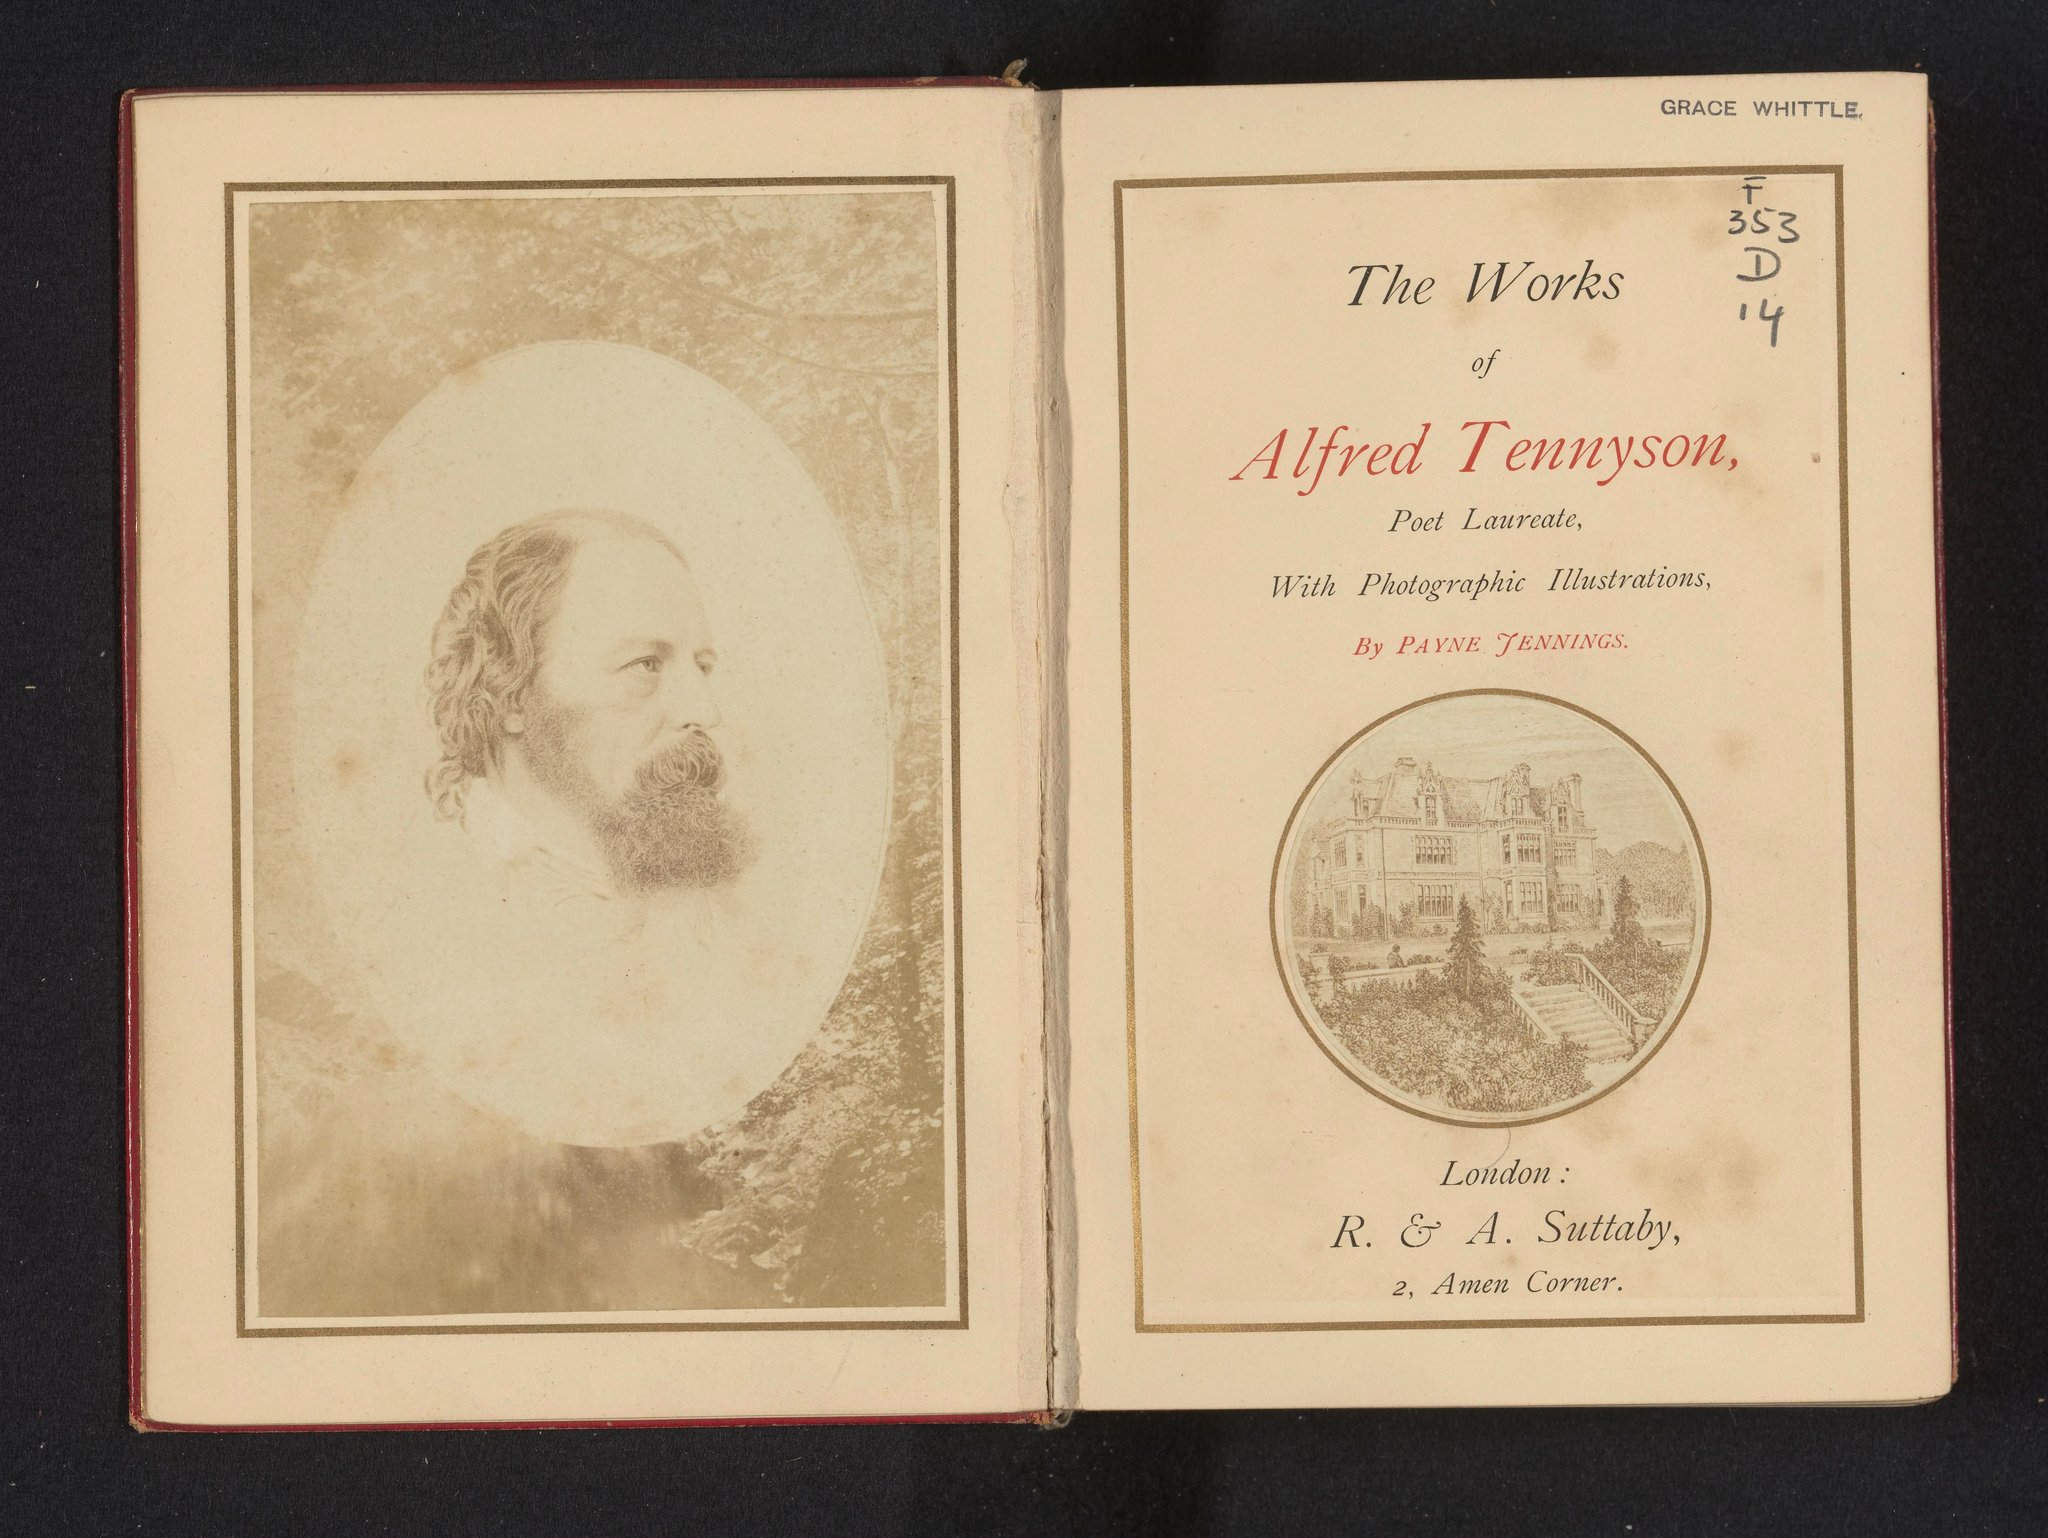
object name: photograph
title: Fotoreproductie van een tekening, voorstellende een gezicht op Aldworth House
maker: john payne jennings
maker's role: fotograaf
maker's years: 1843-1926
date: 1873-1878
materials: photographic support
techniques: albumen print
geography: sussex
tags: façade (of house or building)